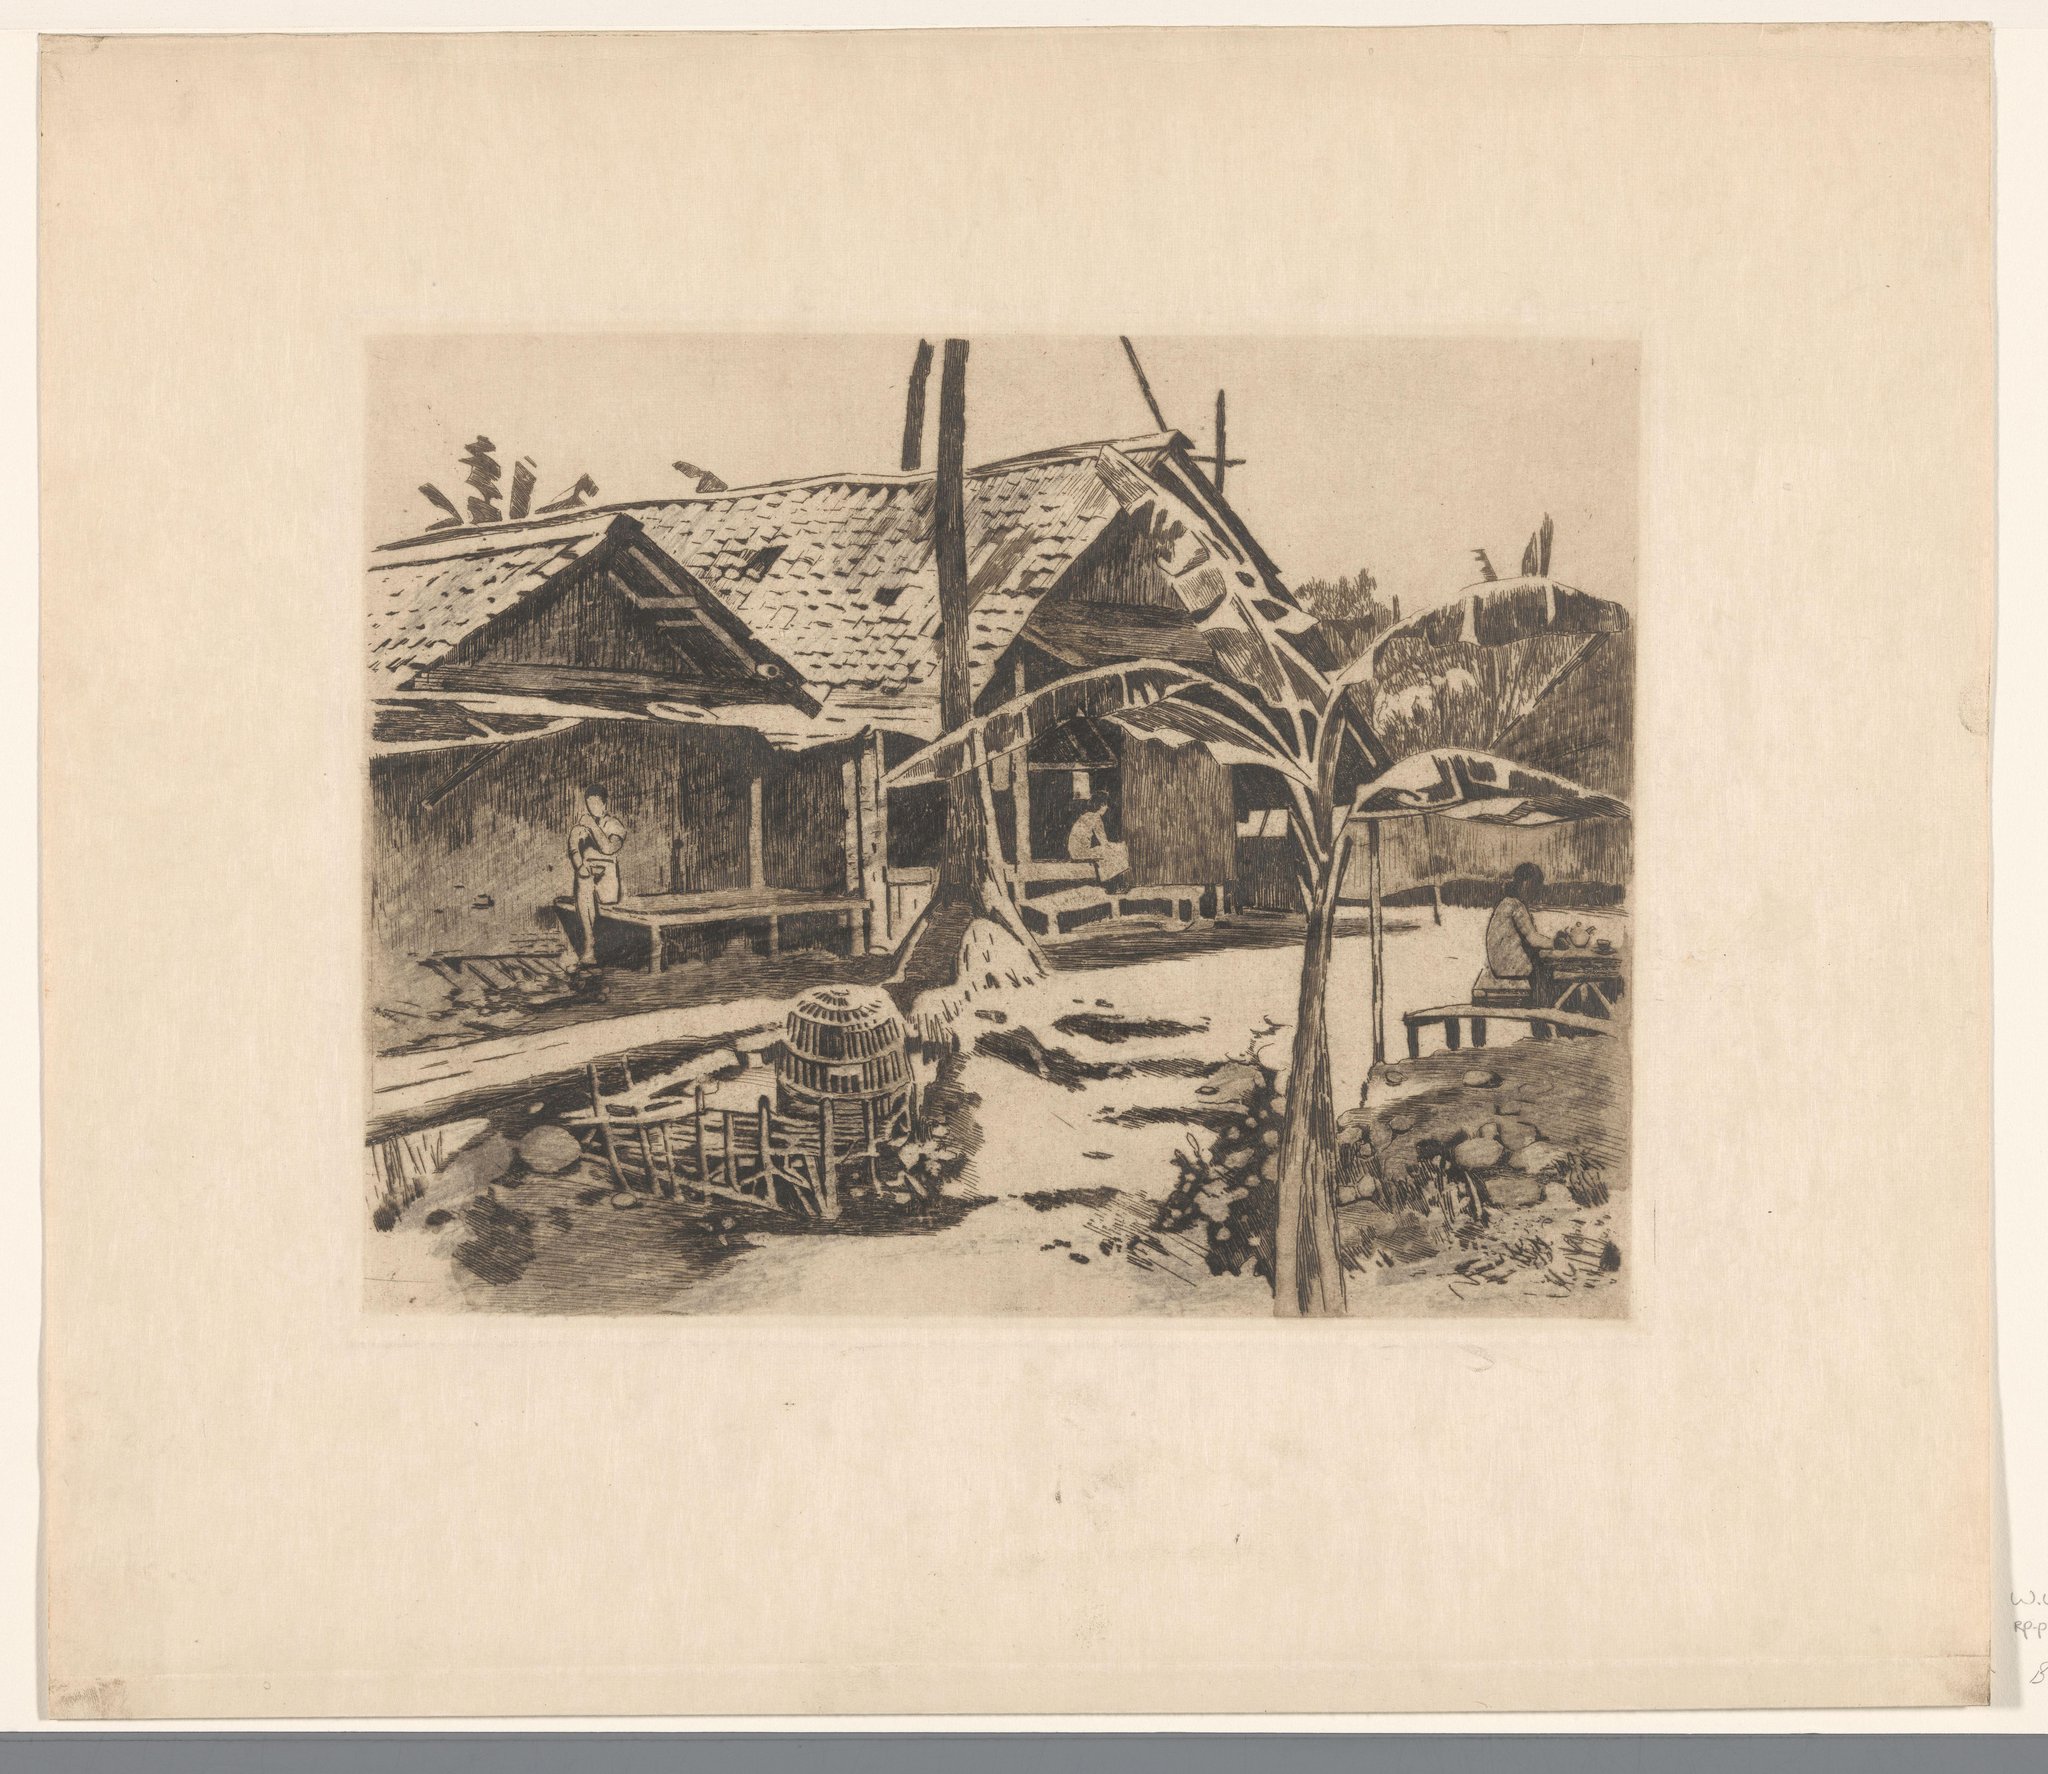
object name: print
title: Pisangboom in een kampong in Buitenzorg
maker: willem witsen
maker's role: draughtsman, painter, print maker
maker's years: 1860-1923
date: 1921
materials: chalk, paper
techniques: aquatint, etching, intaglio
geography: amsterdam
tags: trees, sitting figure, village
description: Links, midden en rechts zijn drie zittende figuren afgebeeld.